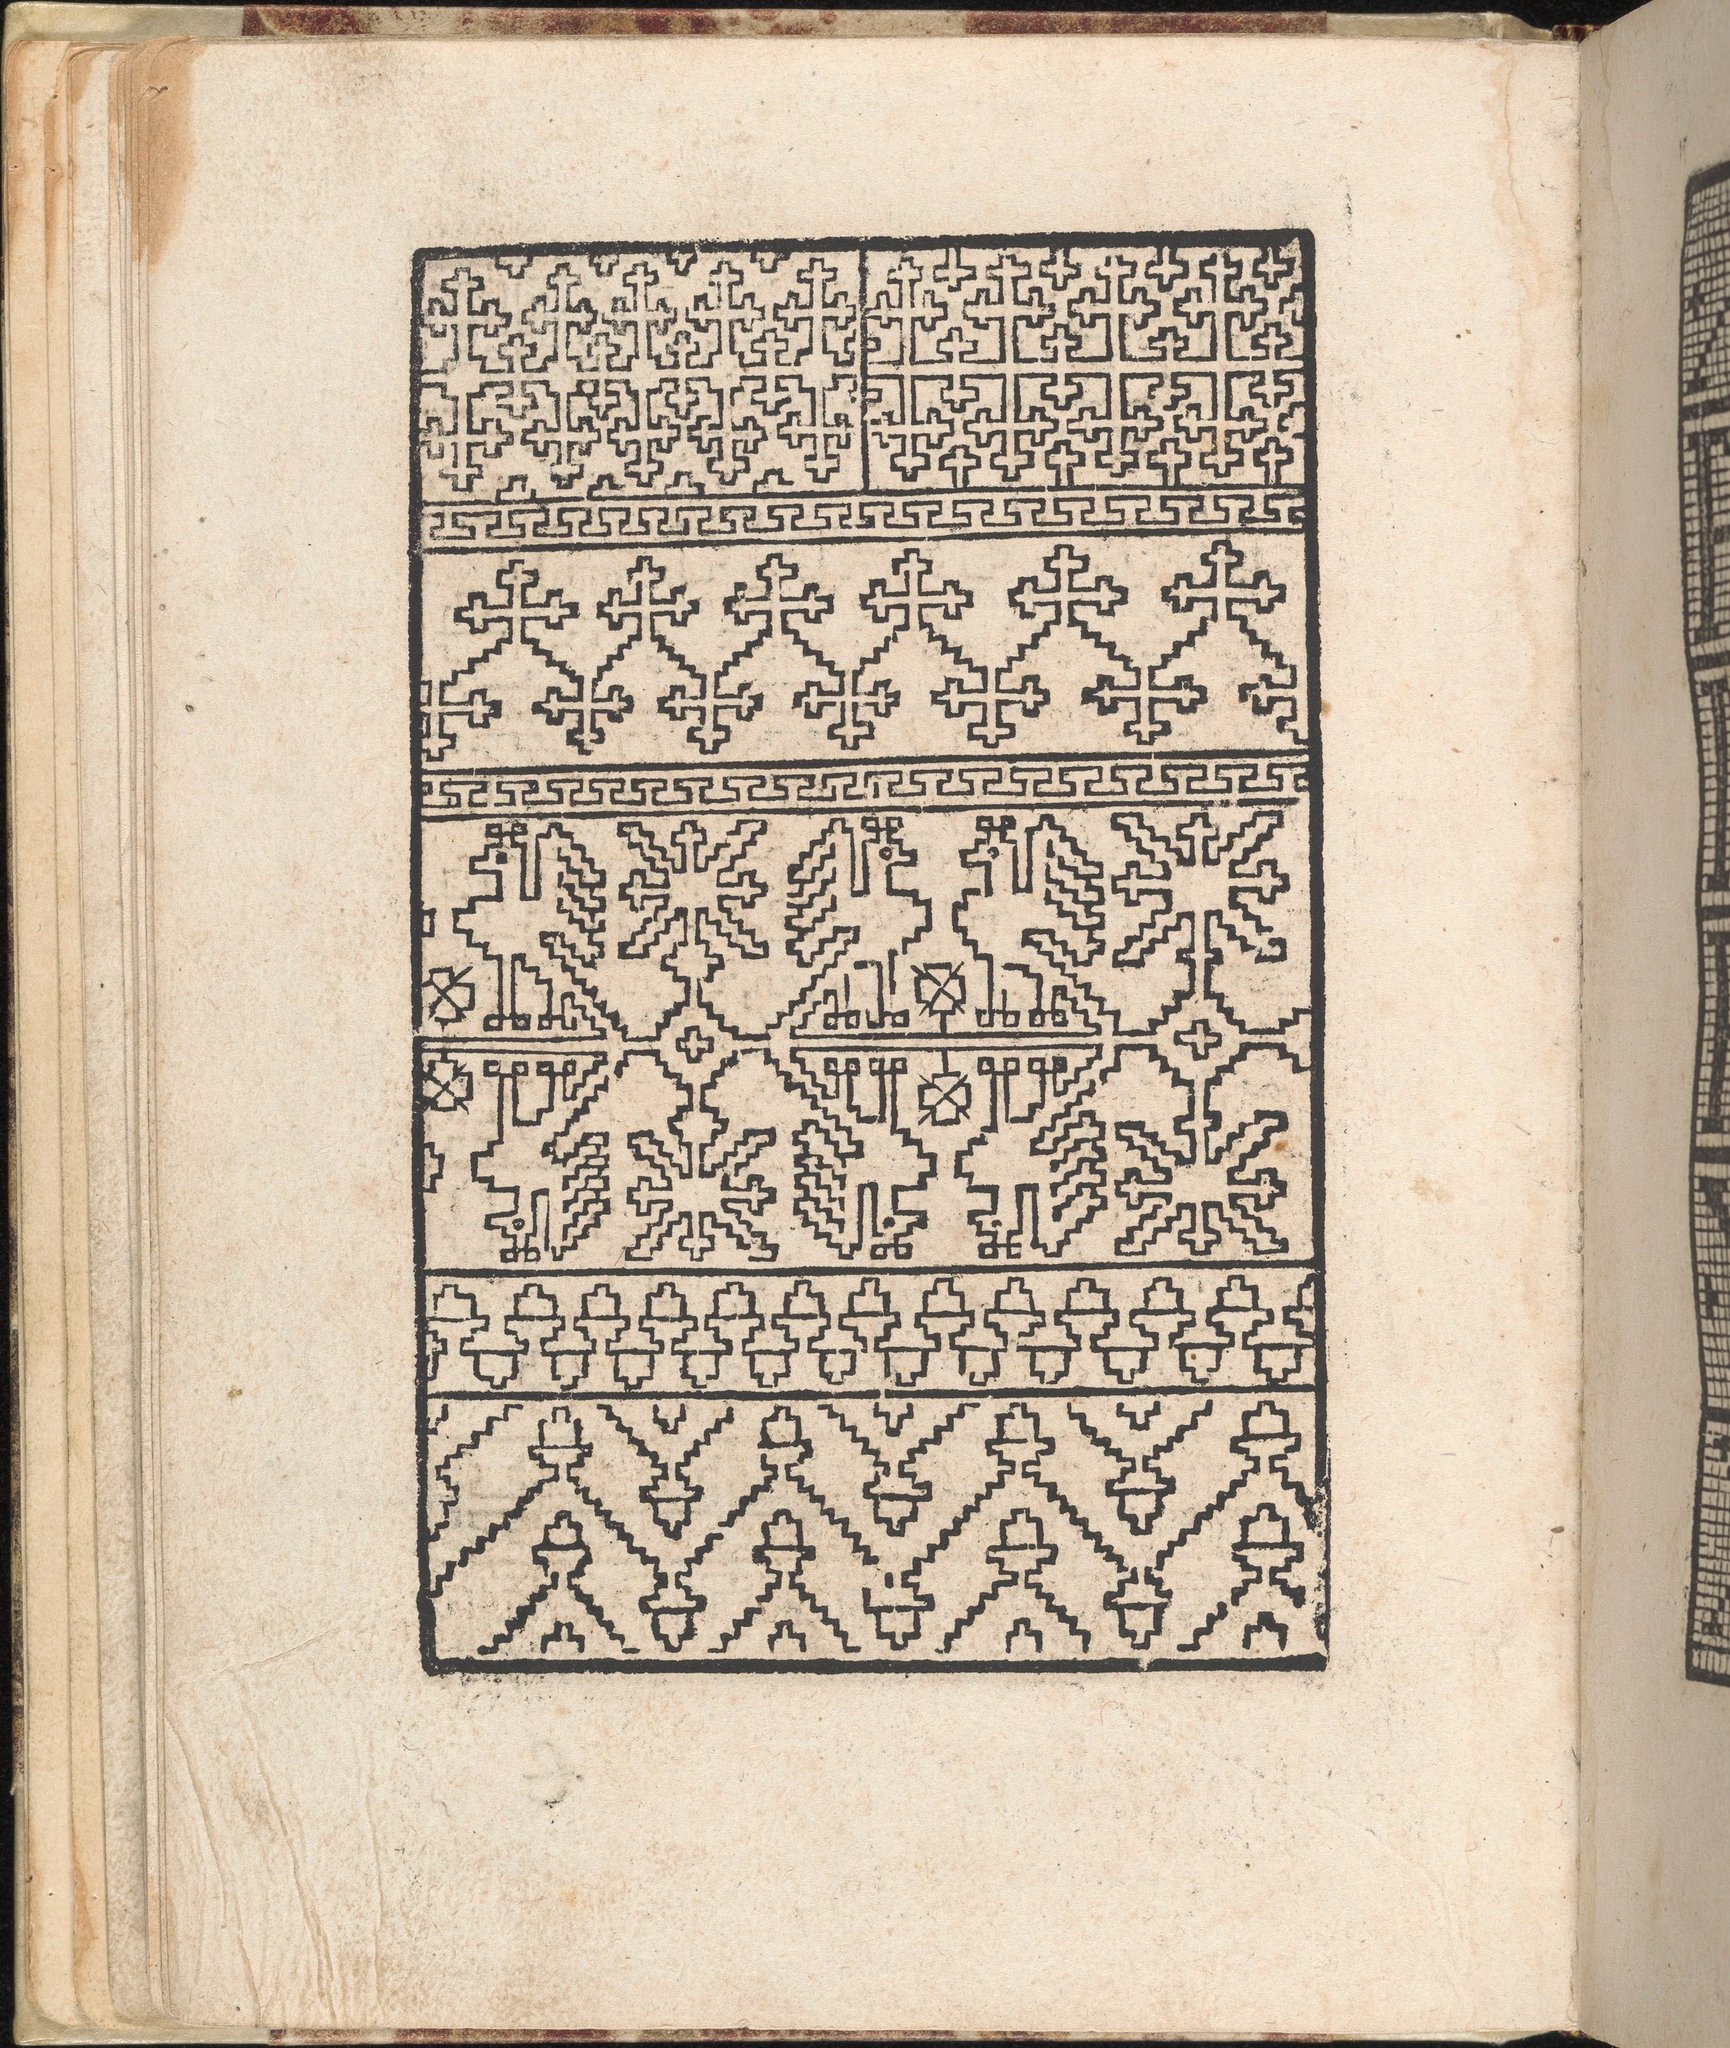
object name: book print ornament architecture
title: Ein new getruckt model Büchli...Page 18, recto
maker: johann schönsperger the younger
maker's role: publisher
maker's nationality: german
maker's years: 1490-1550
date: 1529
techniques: woodcut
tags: ornament